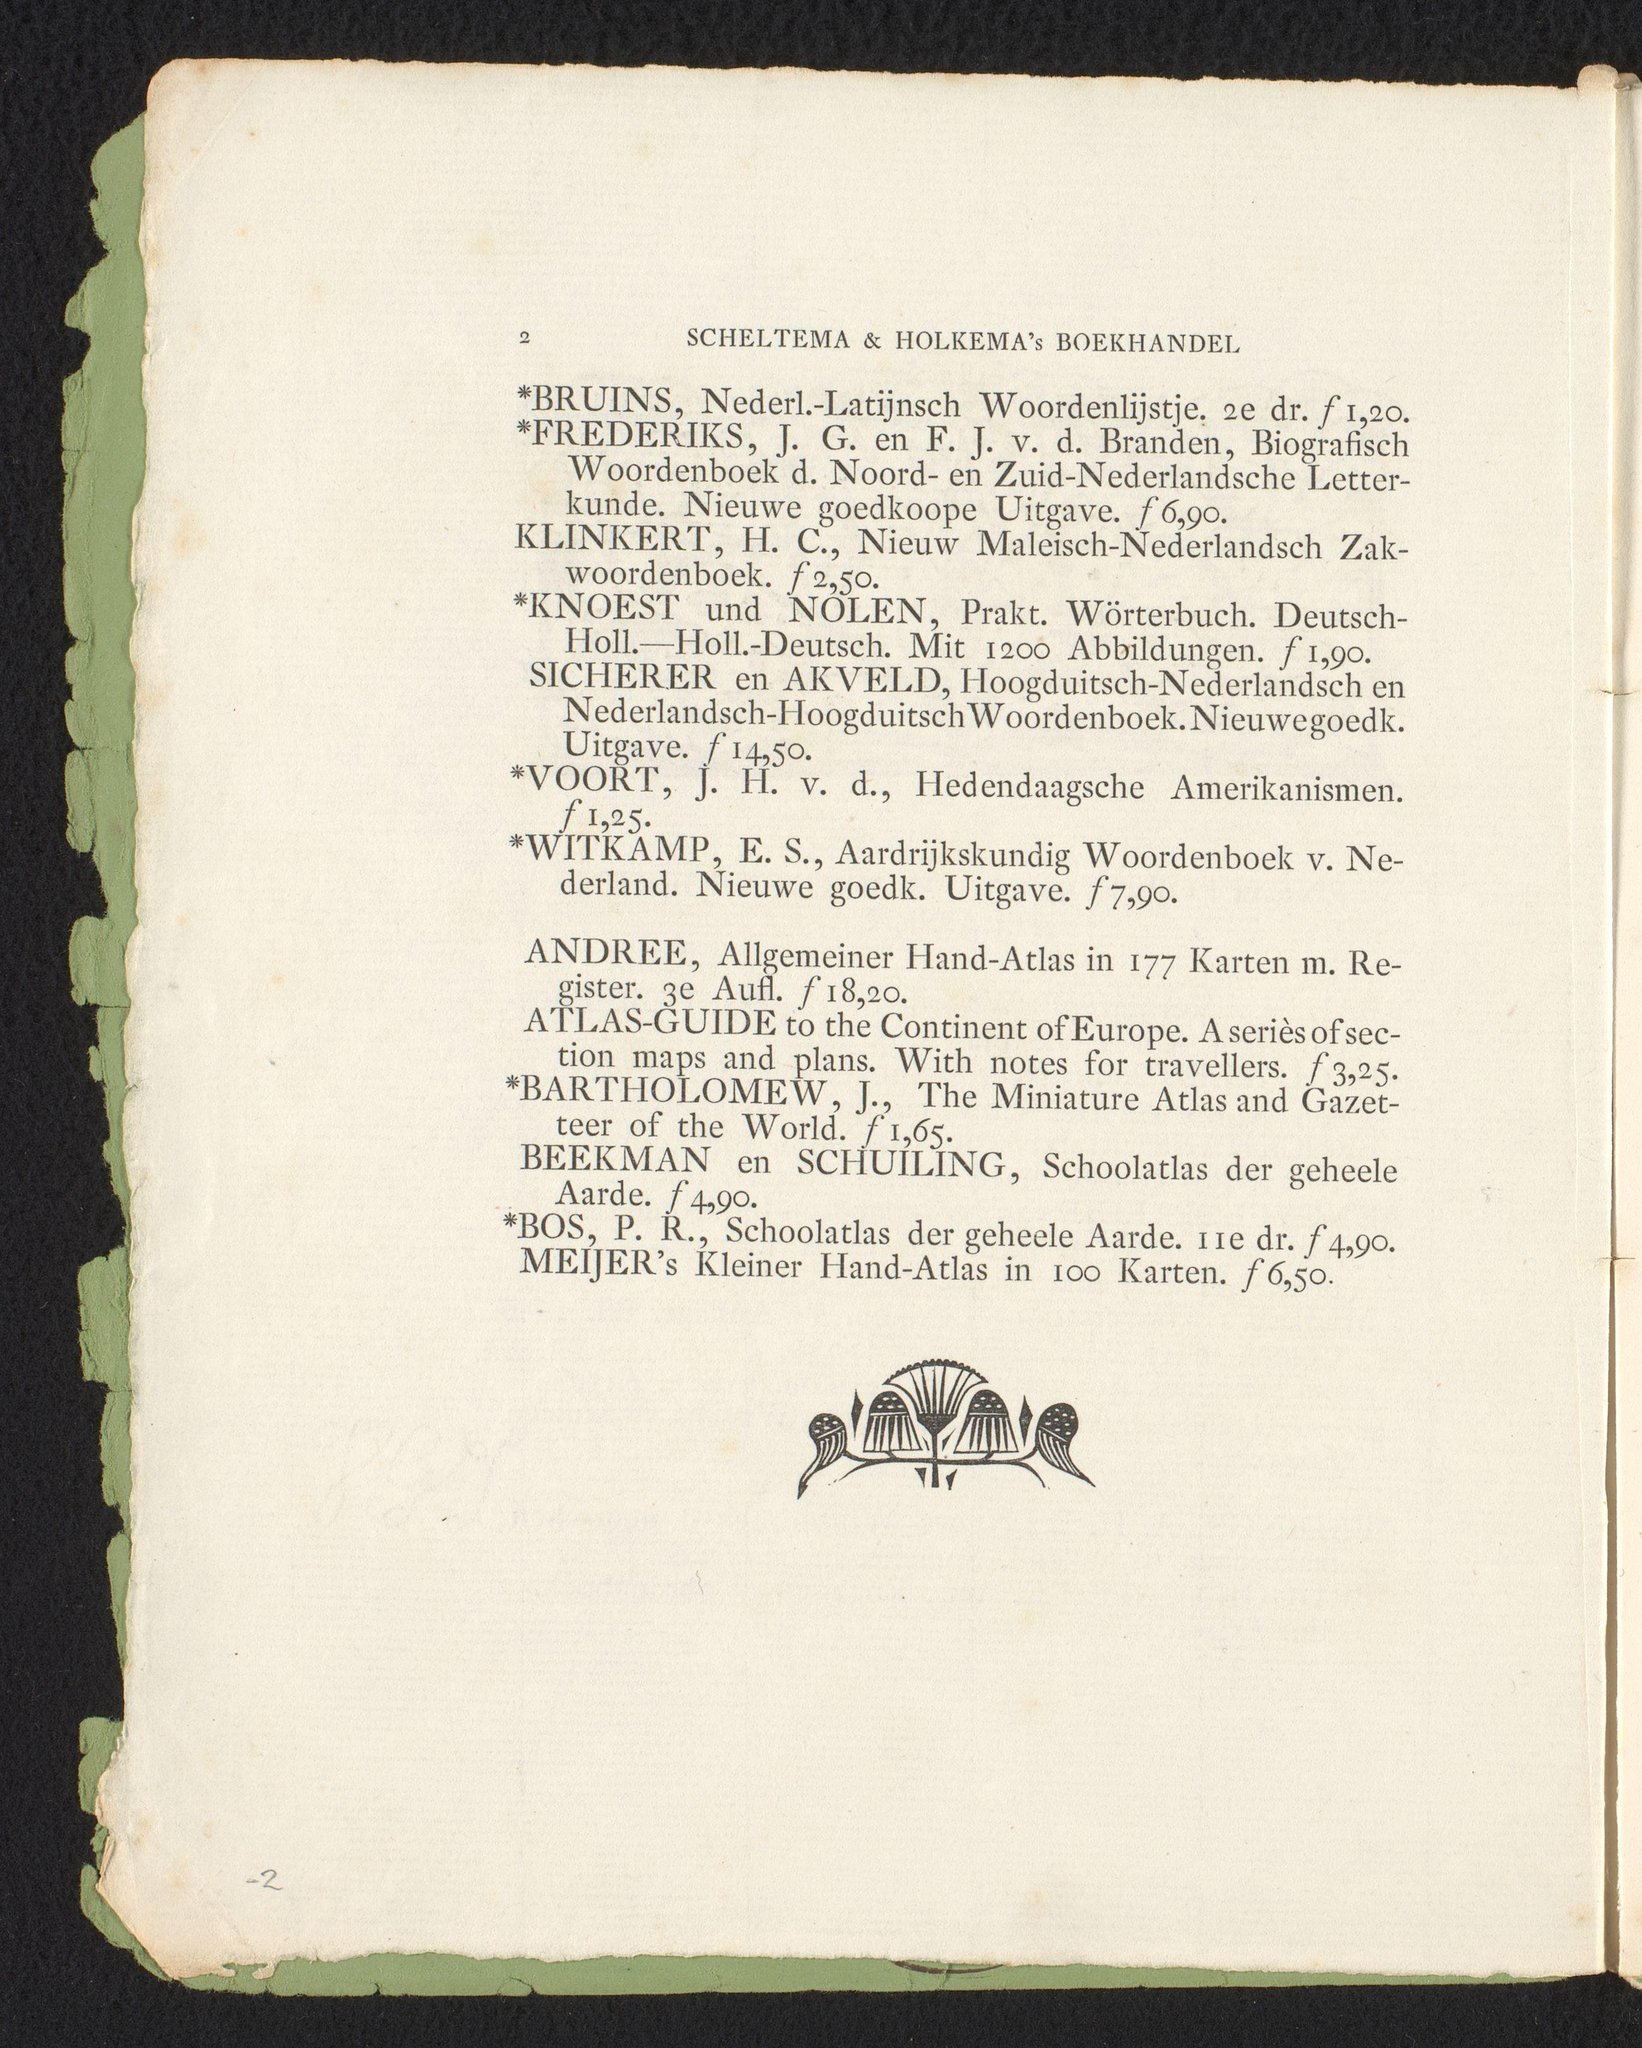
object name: print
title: Vignet met distels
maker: gerrit willem dijsselhof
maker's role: designer, draughtsman, print maker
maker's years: 1866-1924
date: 1893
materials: paper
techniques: letterpress printing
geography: amsterdam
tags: plants and herbs: thistle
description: Prent uit: Catalogus van handboeken, pracht- en plaatwerken, dicht- en prozabundels en kinderliteratuur (...). Amsterdam: Scheltema & Holkema's Boekhandel, 1894, p. 2. Variant van het vignet dat origineel werd ontworpen voor: Crane, Walter. Kunst en samenleving. [Vertaald uit het Engels door] Jan Veth. Amsterdam: Scheltema & Holkema's Boekhandel, 1894 [1893].